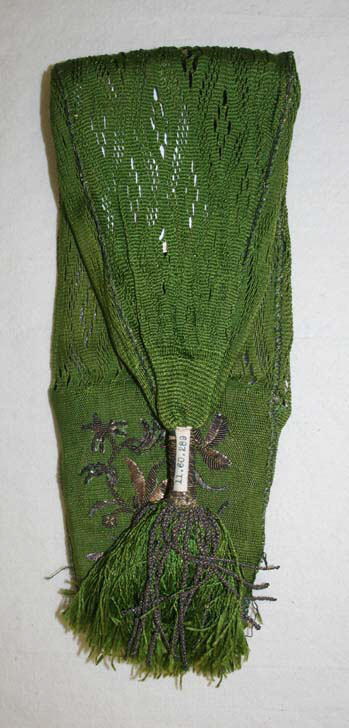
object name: purse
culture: american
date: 1801-1900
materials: metal, silk